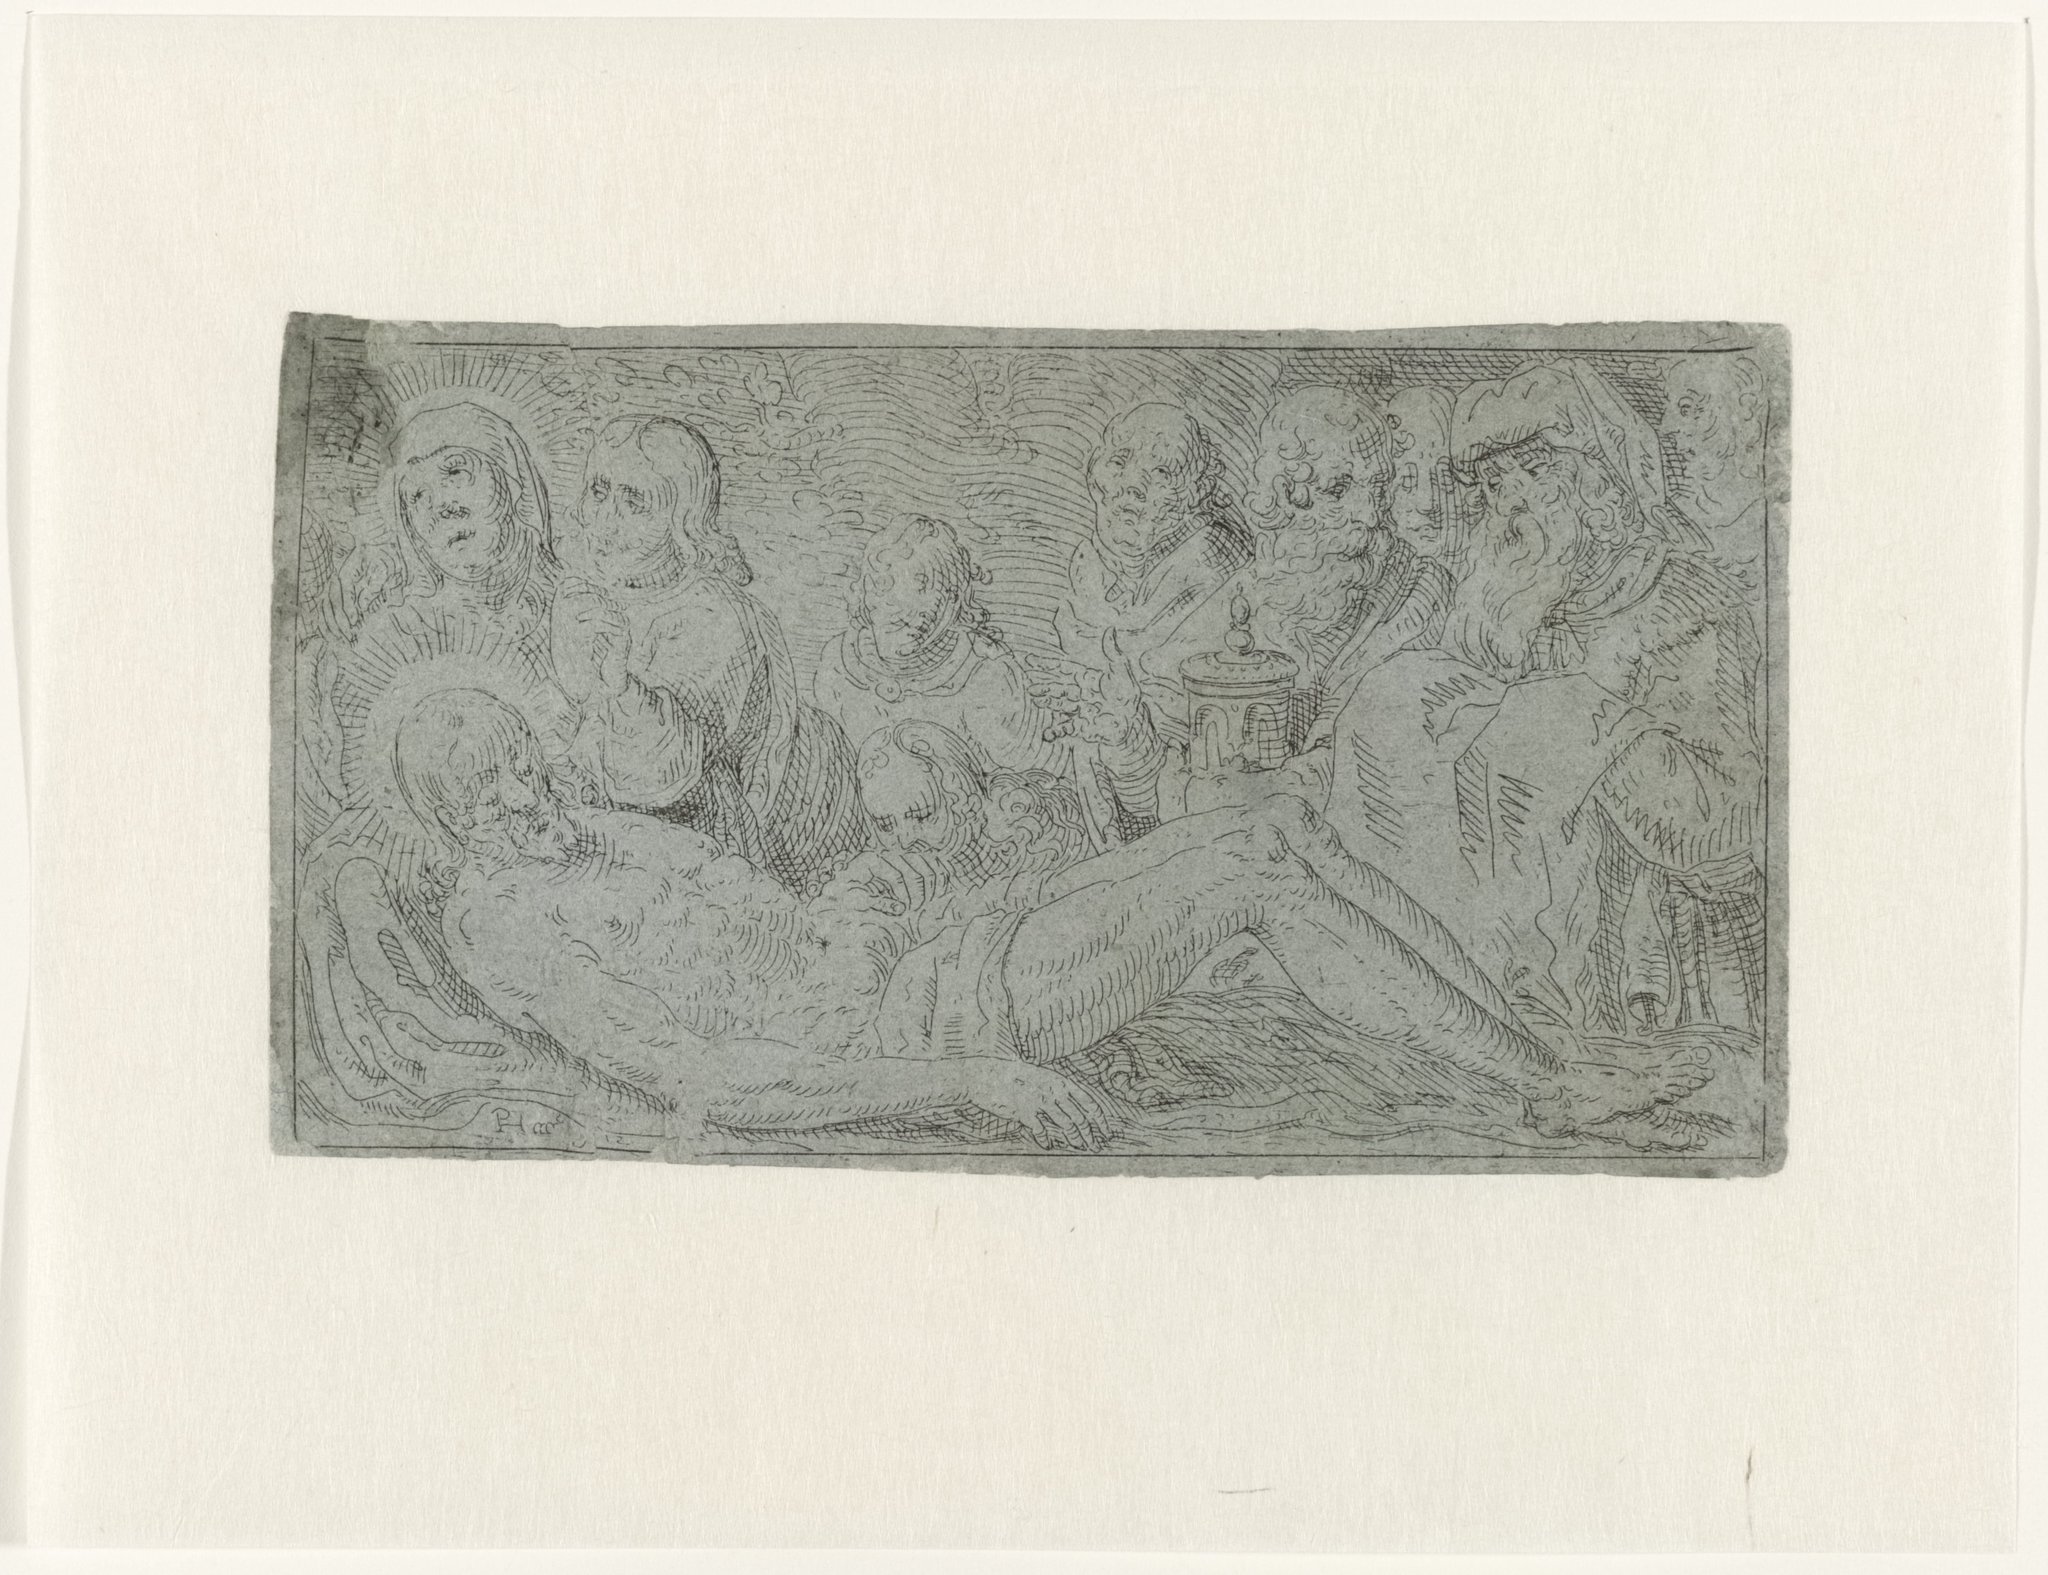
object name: print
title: De dode Christus met Maria en rouwende discipelen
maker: pieter feddes van harlingen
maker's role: painter, print maker, publisher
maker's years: 1586-1623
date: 1612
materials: paper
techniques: etching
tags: lamentation over the dead christ by his relatives and friends (christ usually without crown of thorns)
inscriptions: date